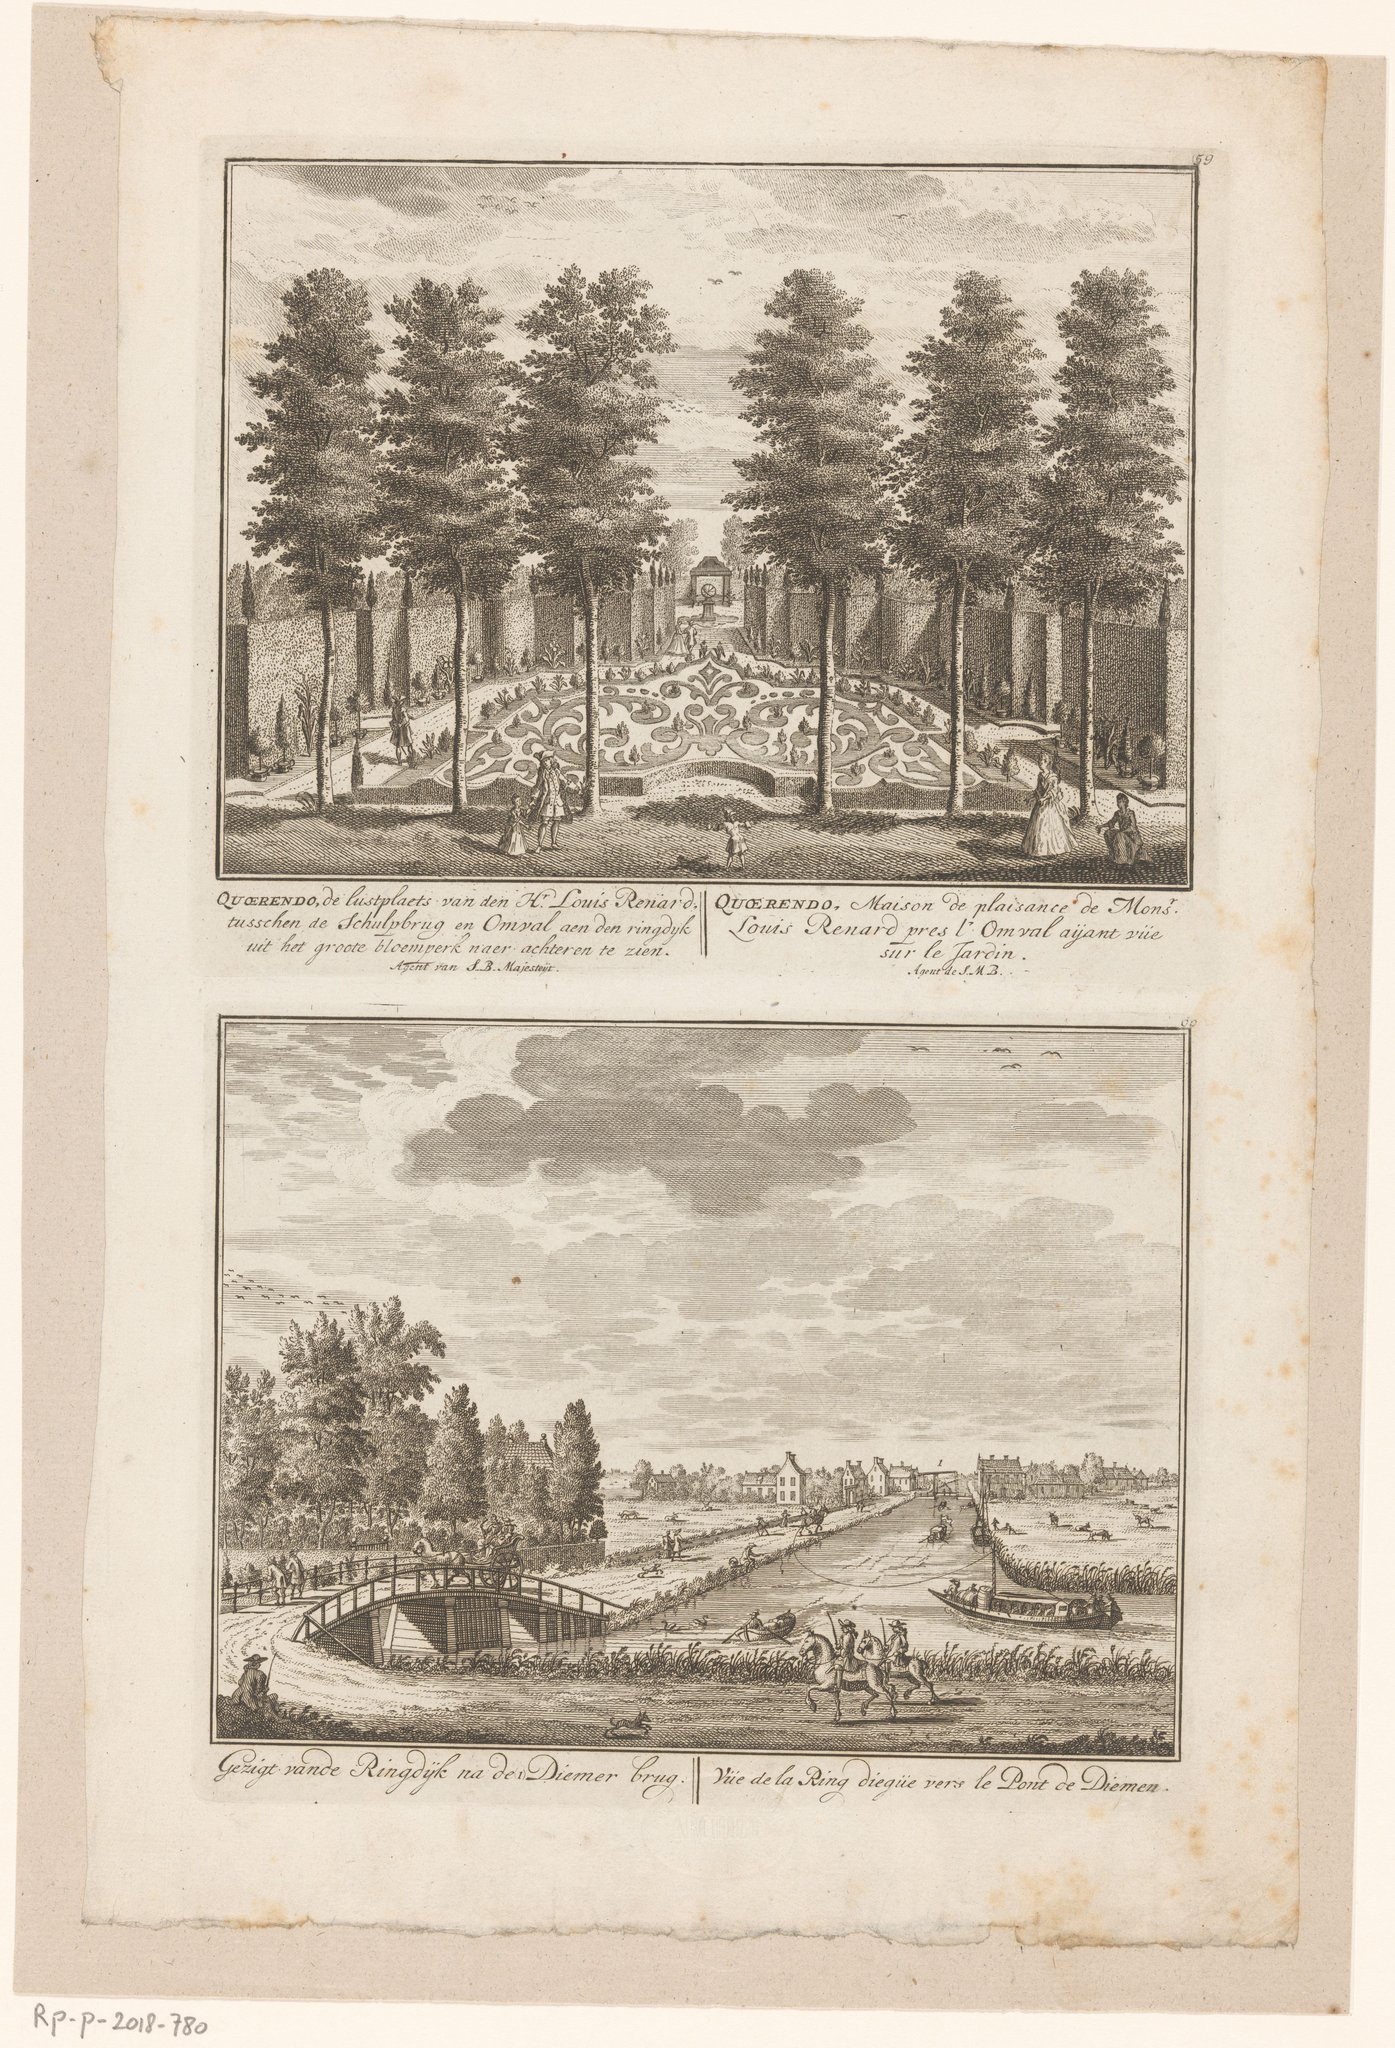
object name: print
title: Quoerendo, de lustplaets van den hr. Louis Renard, tusschen de Schulpbrug (...) / Quoerendo, maison de plaisance de monsr. Louis Renard pres (...)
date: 1725-1768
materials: paper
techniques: engraving, etching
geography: amsterdam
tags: french or architectonic garden; formal garden, country-house, amsterdam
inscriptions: check stamp: ‘Archief Ministerie van Oorlog Afdeeling Genie’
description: Prent gebruikt in: Niedek, Mattaeus Brouërius. Het verheerlykt Watergraafs- of Diemermeer by de stadt Amsterdam (...). Amsterdam: Andries en Hendrik de Leth, 1725. Of in: Niedek, Mattaeus Brouërius. Het verheerlykt Watergraafs- of Diemermeer by de stadt Amsterdam (...). Amsterdam: Pieter Jan Entrop, 1768.